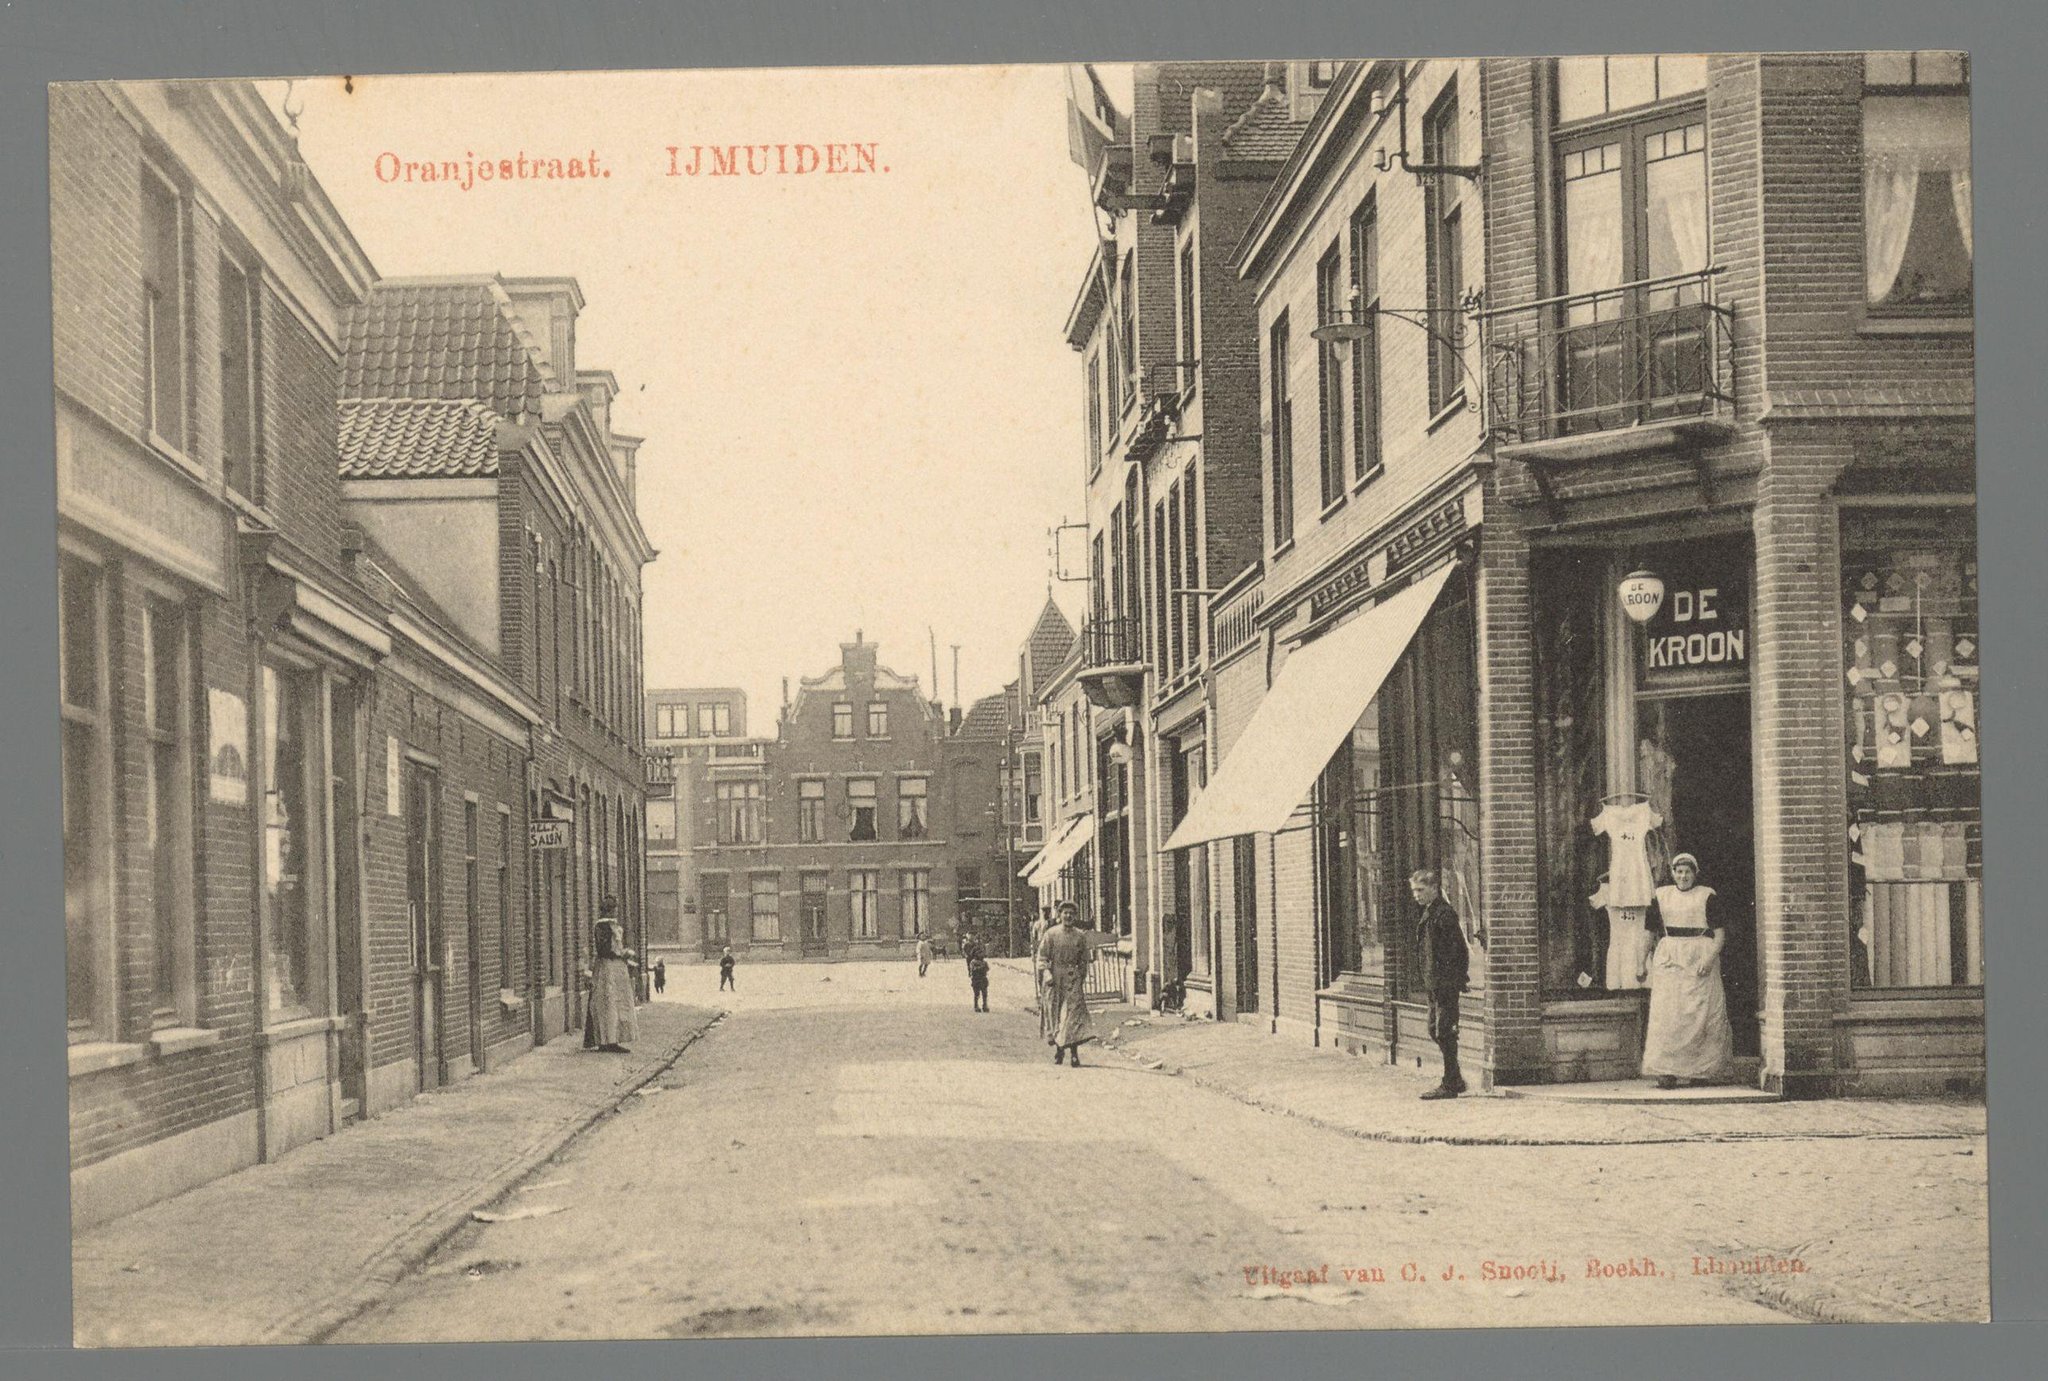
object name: ansichtkaart, prentbriefkaart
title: Oranjestraat. IJmuiden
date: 1905-1927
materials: cardboard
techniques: photograph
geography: ijmuiden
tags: shop, store, street